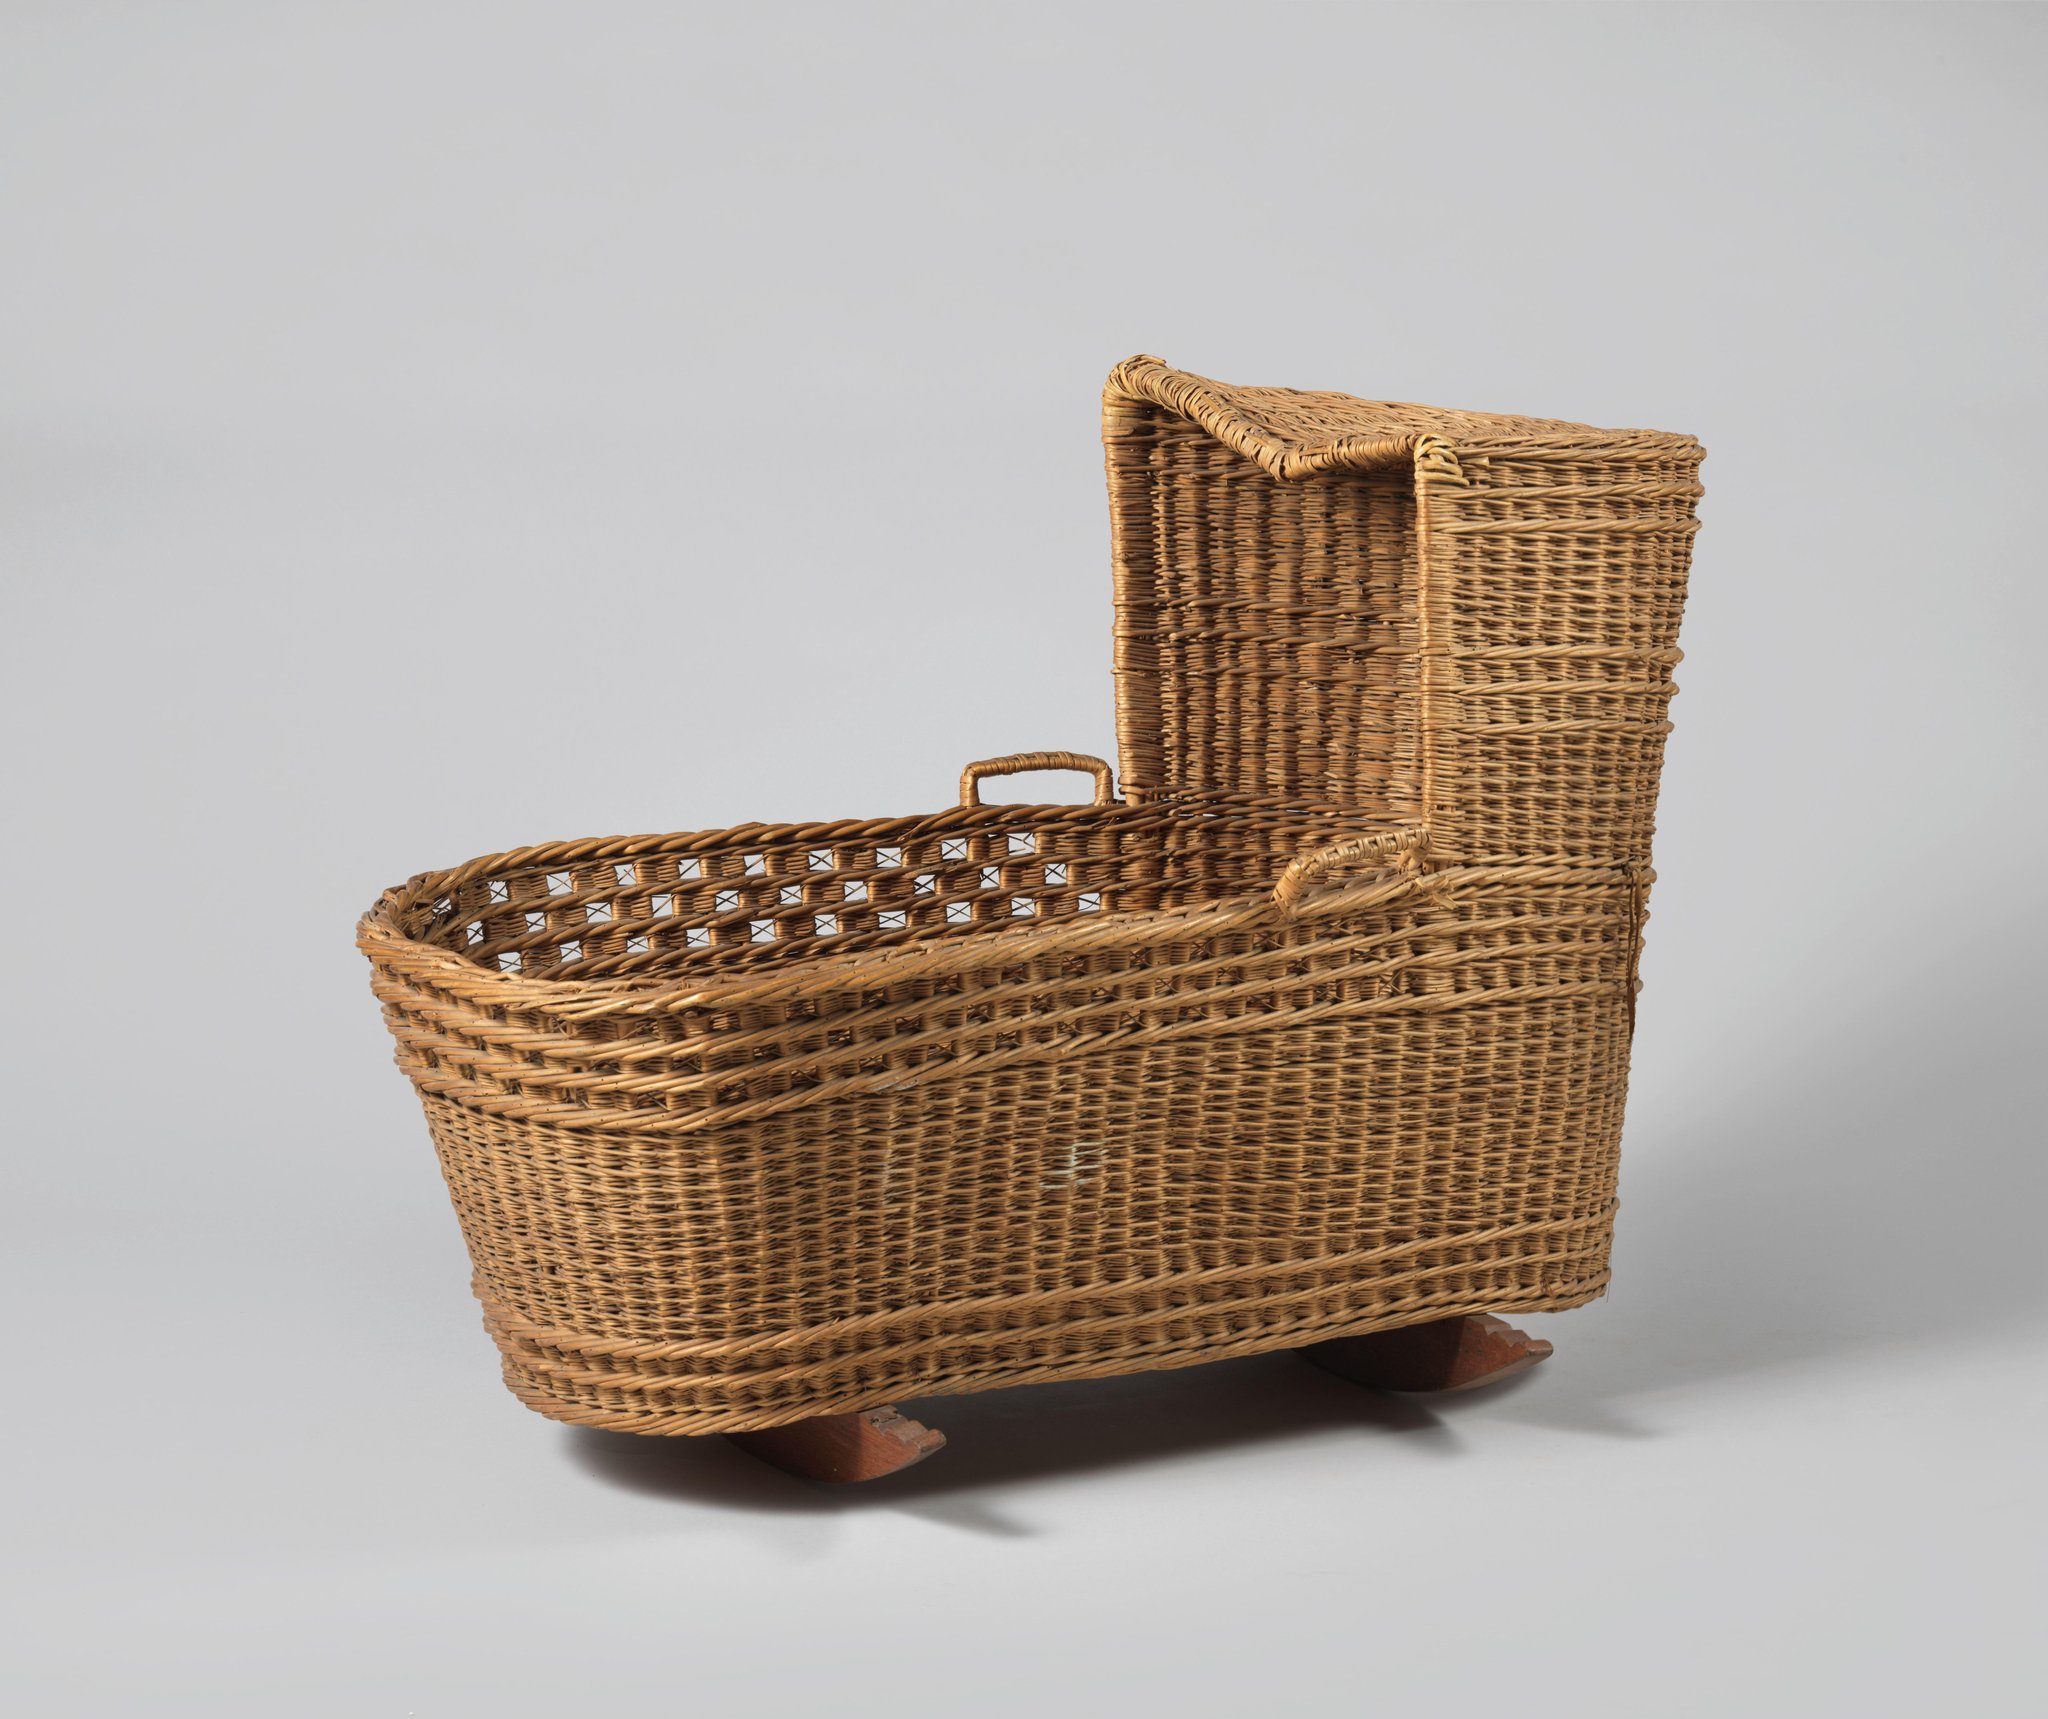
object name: wieg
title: Wieg van eikentenen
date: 1800-1900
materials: wood